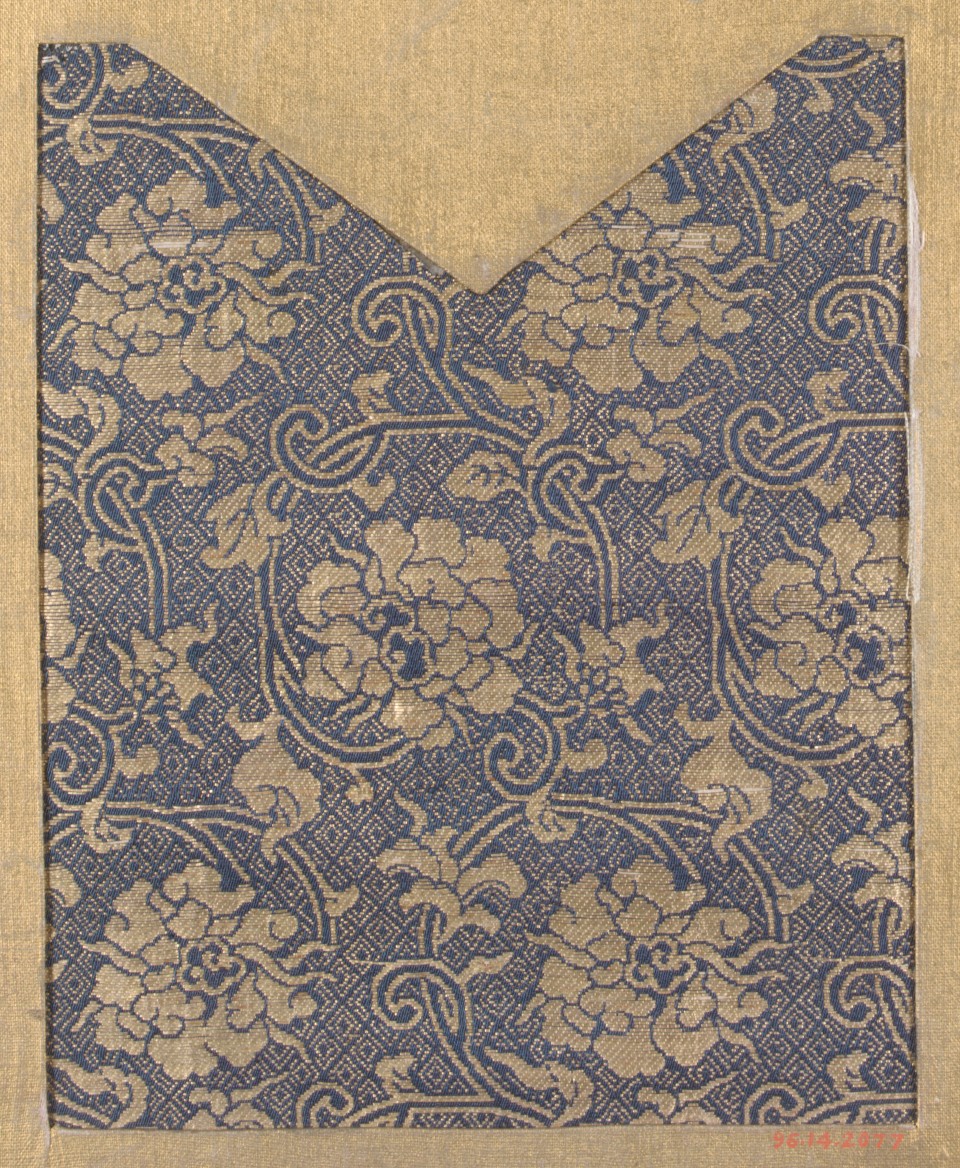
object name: piece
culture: japanese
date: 1701-1900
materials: silk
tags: leaves